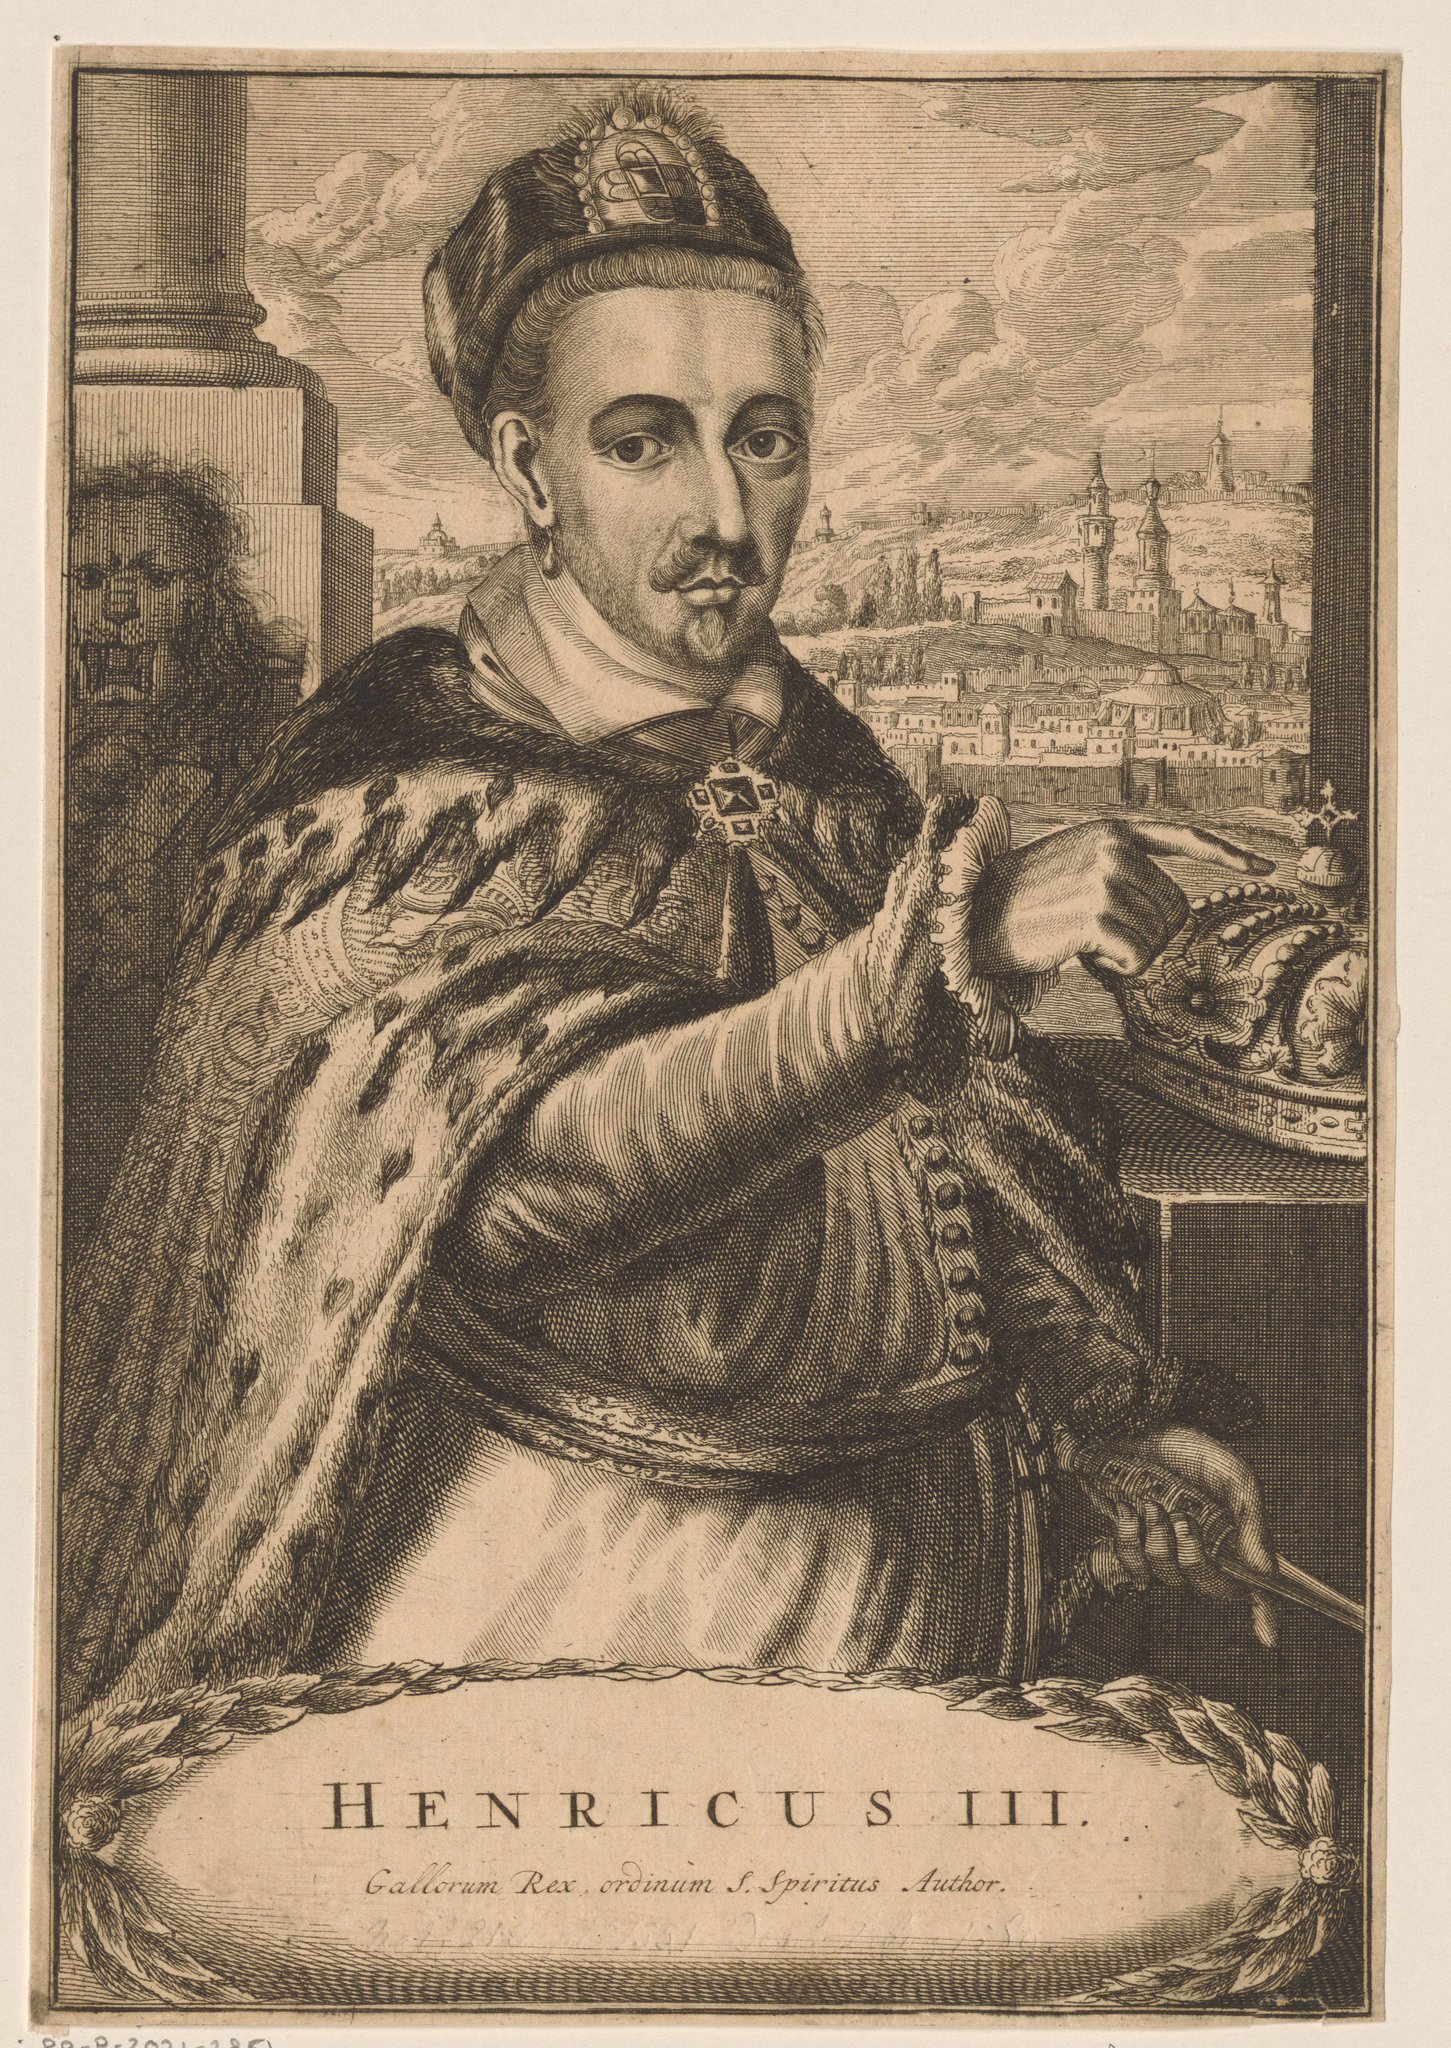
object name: print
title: Portret van Hendrik III, koning van Frankrijk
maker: Anonymous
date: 1700-1724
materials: paper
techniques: engraving, etching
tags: hendrik iii (koning van frankrijk), city-view in general; 'veduta', historical persons, king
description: Prent mogelijk uit: Principum et illustrium quorundam virorum qui in Europa alibique terrarum (...). Leiden: Pieter van der Aa, s.a.